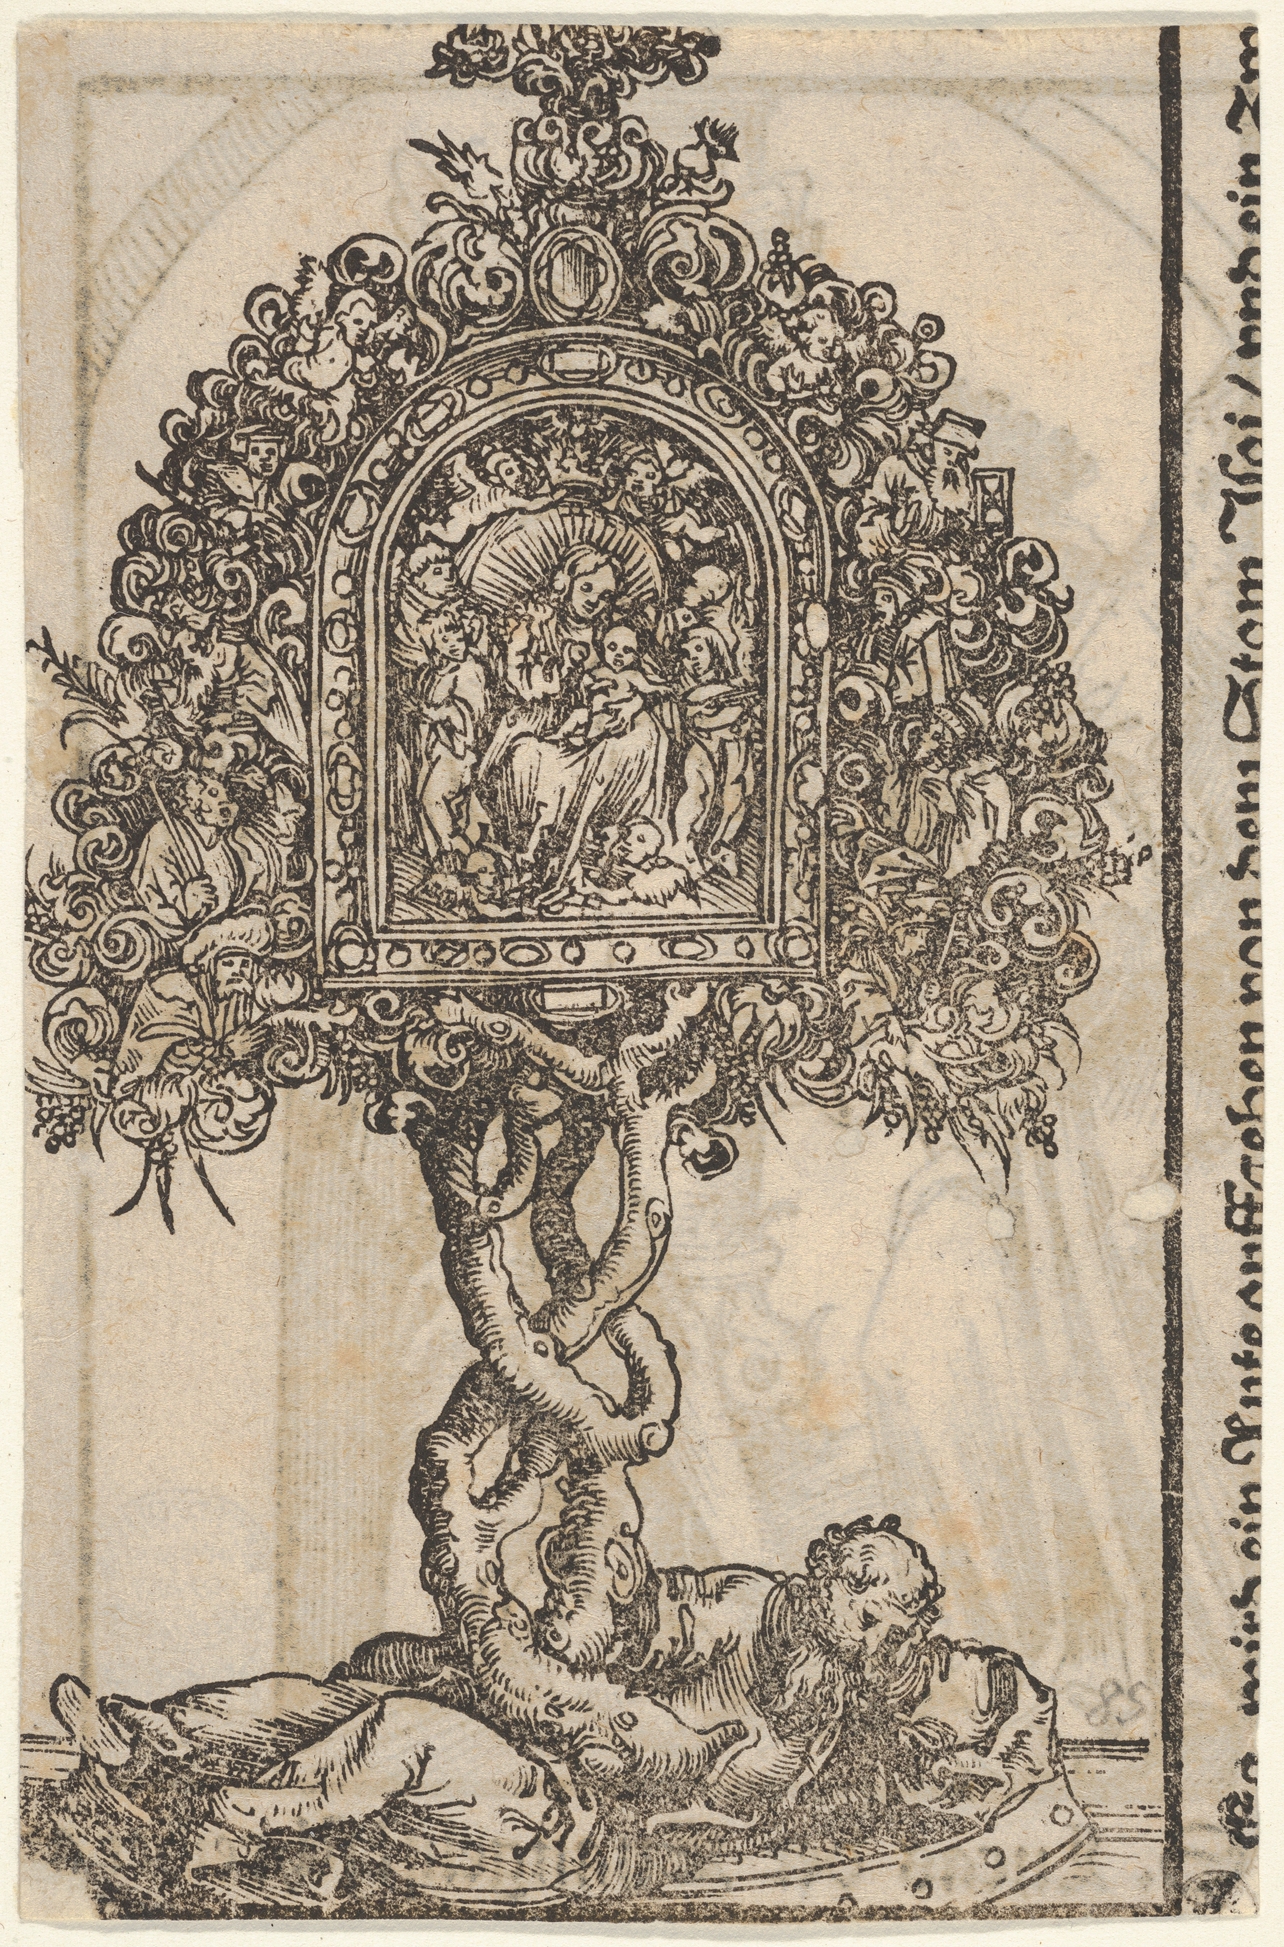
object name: print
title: A Golden Reliquary with the Tree of Jesse, from the "Wittenberg Reliquaries"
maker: lucas cranach the elder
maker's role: artist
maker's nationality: german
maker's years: 1472-1553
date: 1509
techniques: woodcut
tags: trees,angels,madonna and child